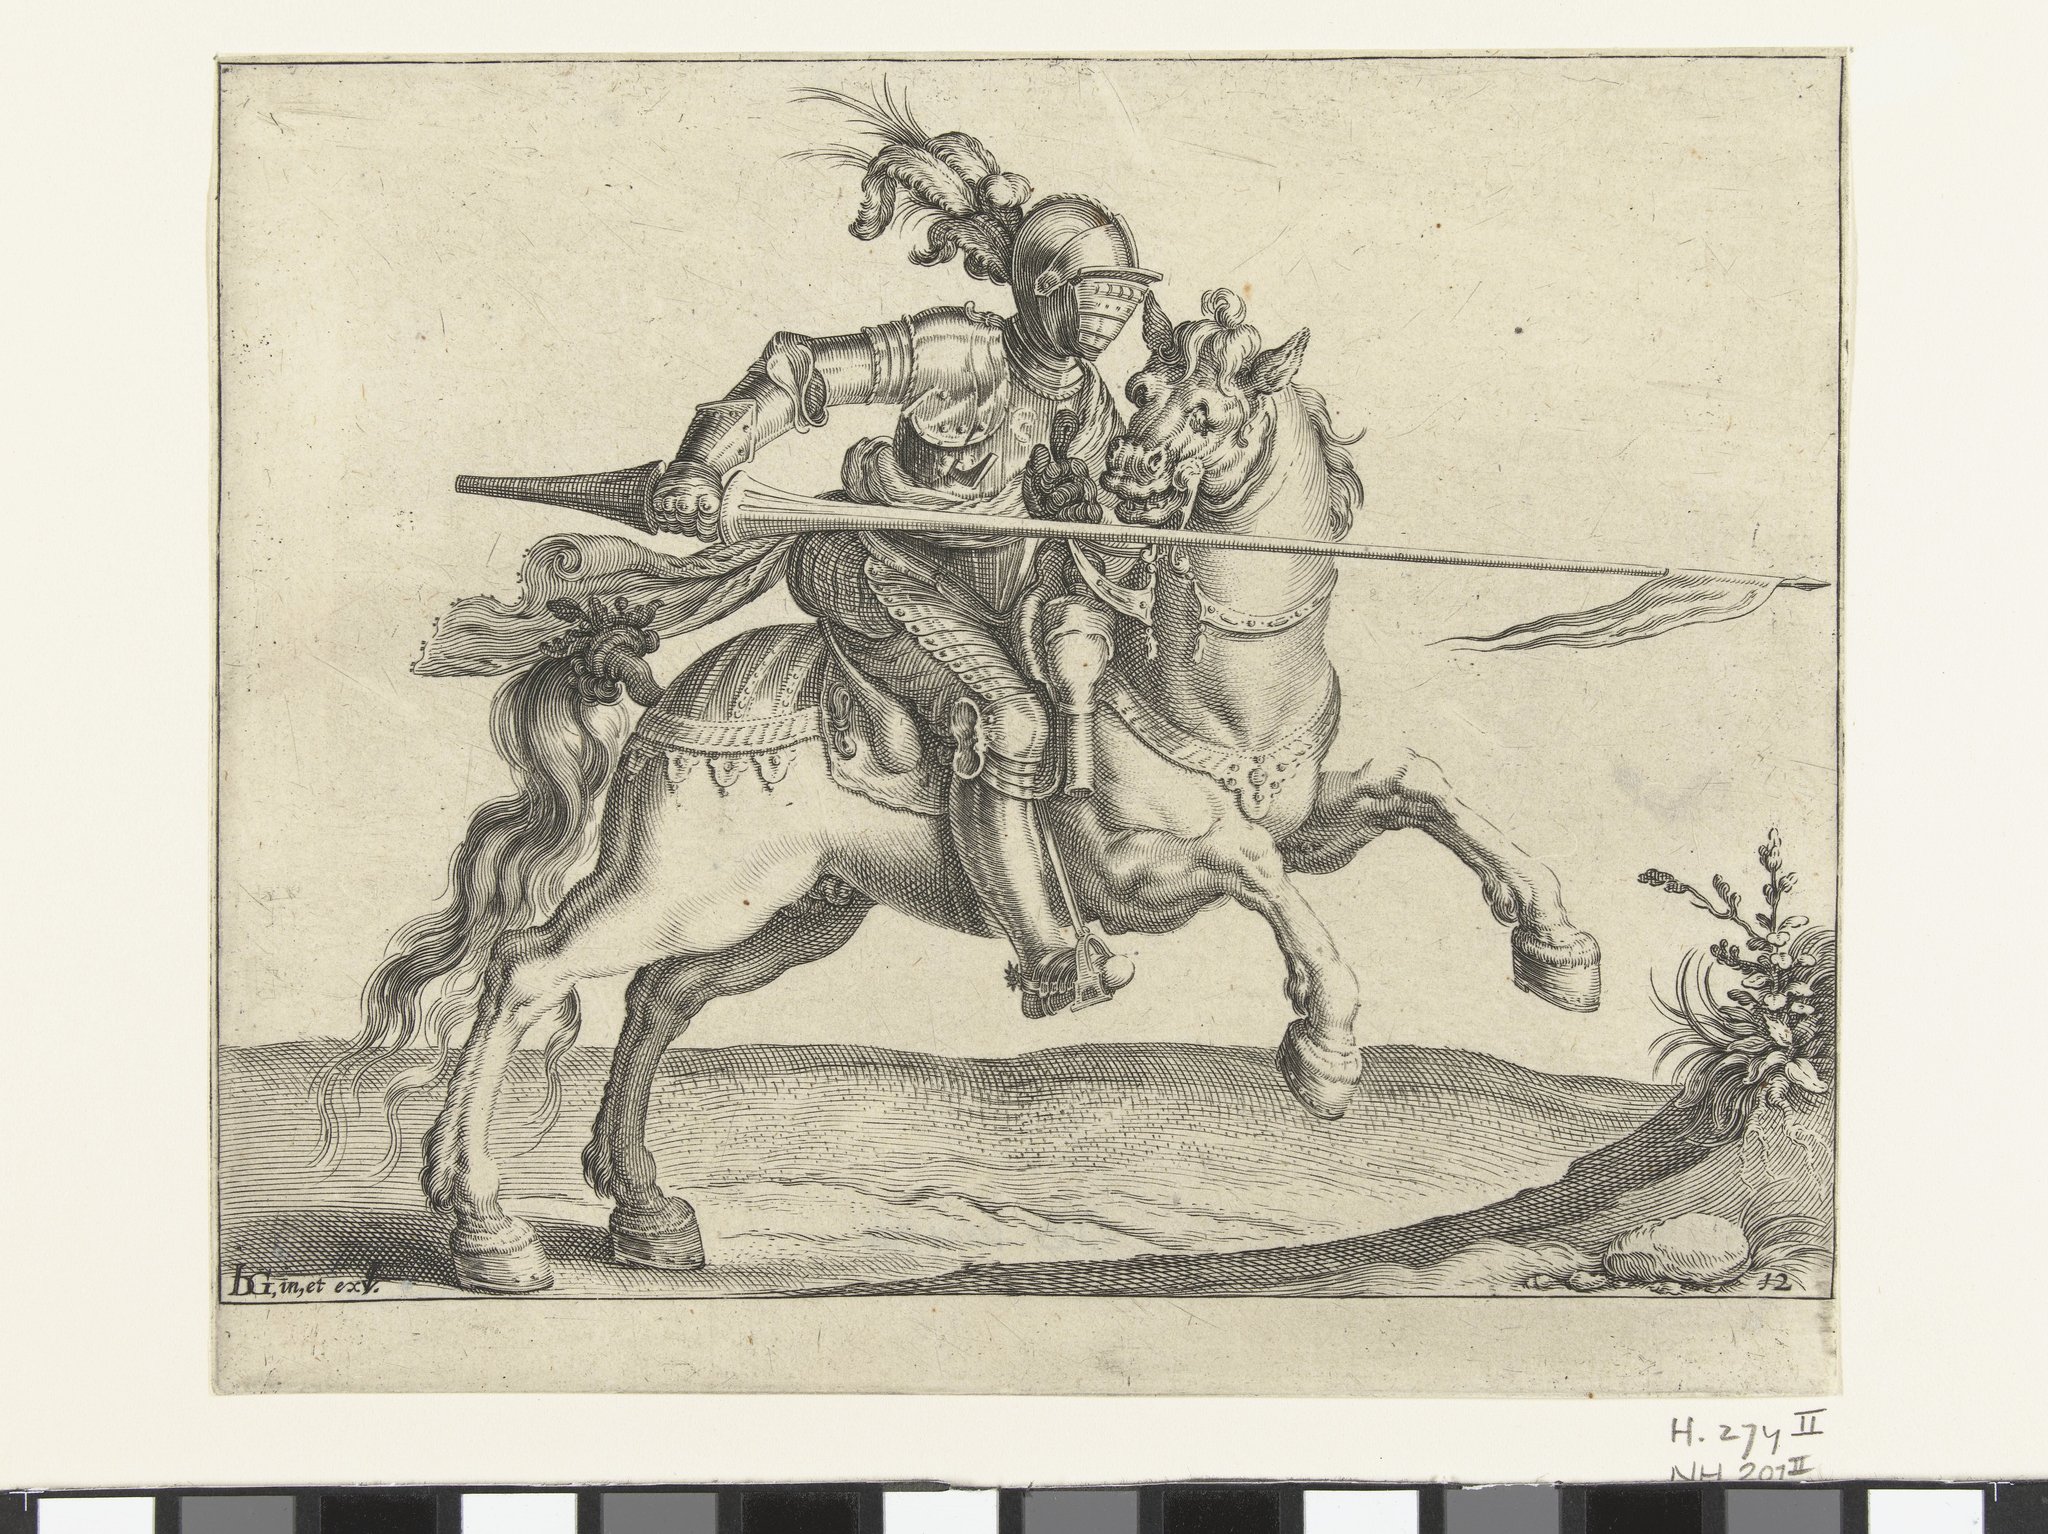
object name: print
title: Speerruiter, aanvallend naar rechts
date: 1599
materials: paper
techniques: engraving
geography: amsterdam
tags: helved weapons, polearms (for striking, hacking, thrusting): lance, warfare; military affairs (+ cavalry, horsemen)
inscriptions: collector's mark: Lugt 2228a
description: Een geharnaste man te paard (speerruiter) rijdt in aanvallende houding, met vooruitgestoken lans, naar rechts. Deze prent is onderdeel van een serie van 22 genummerde prenten: een titelprent, 20 prenten waarop één of enkele verschillende typen (meest geharnaste) ruiters zijn weergegeven, en een prent met een ruitergevecht.